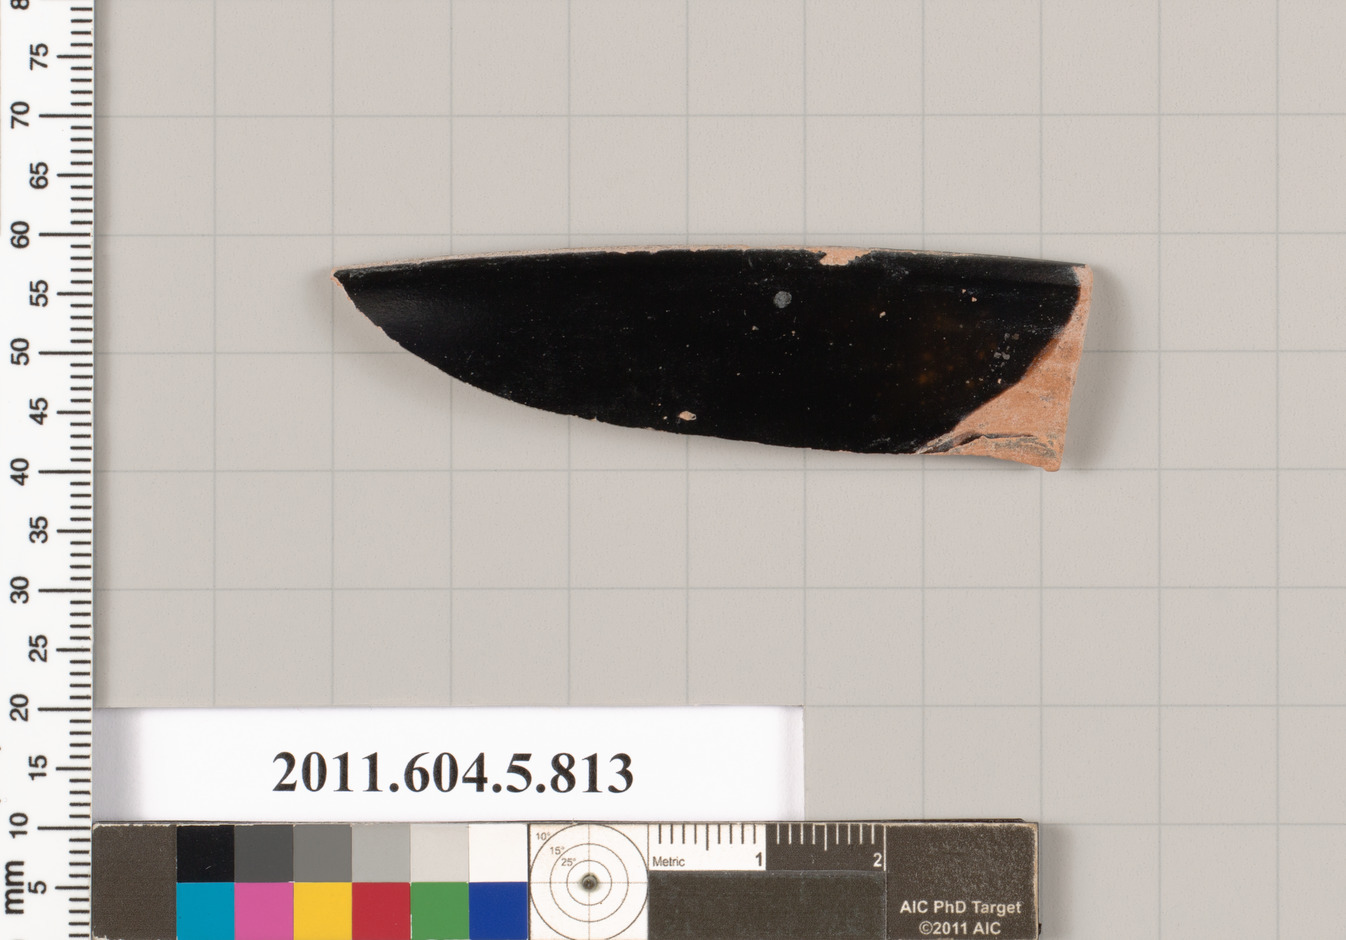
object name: kylix fragment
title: Terracotta rim fragment of a kylix (drinking cup)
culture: greek, attic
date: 600-401 BCE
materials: terracotta